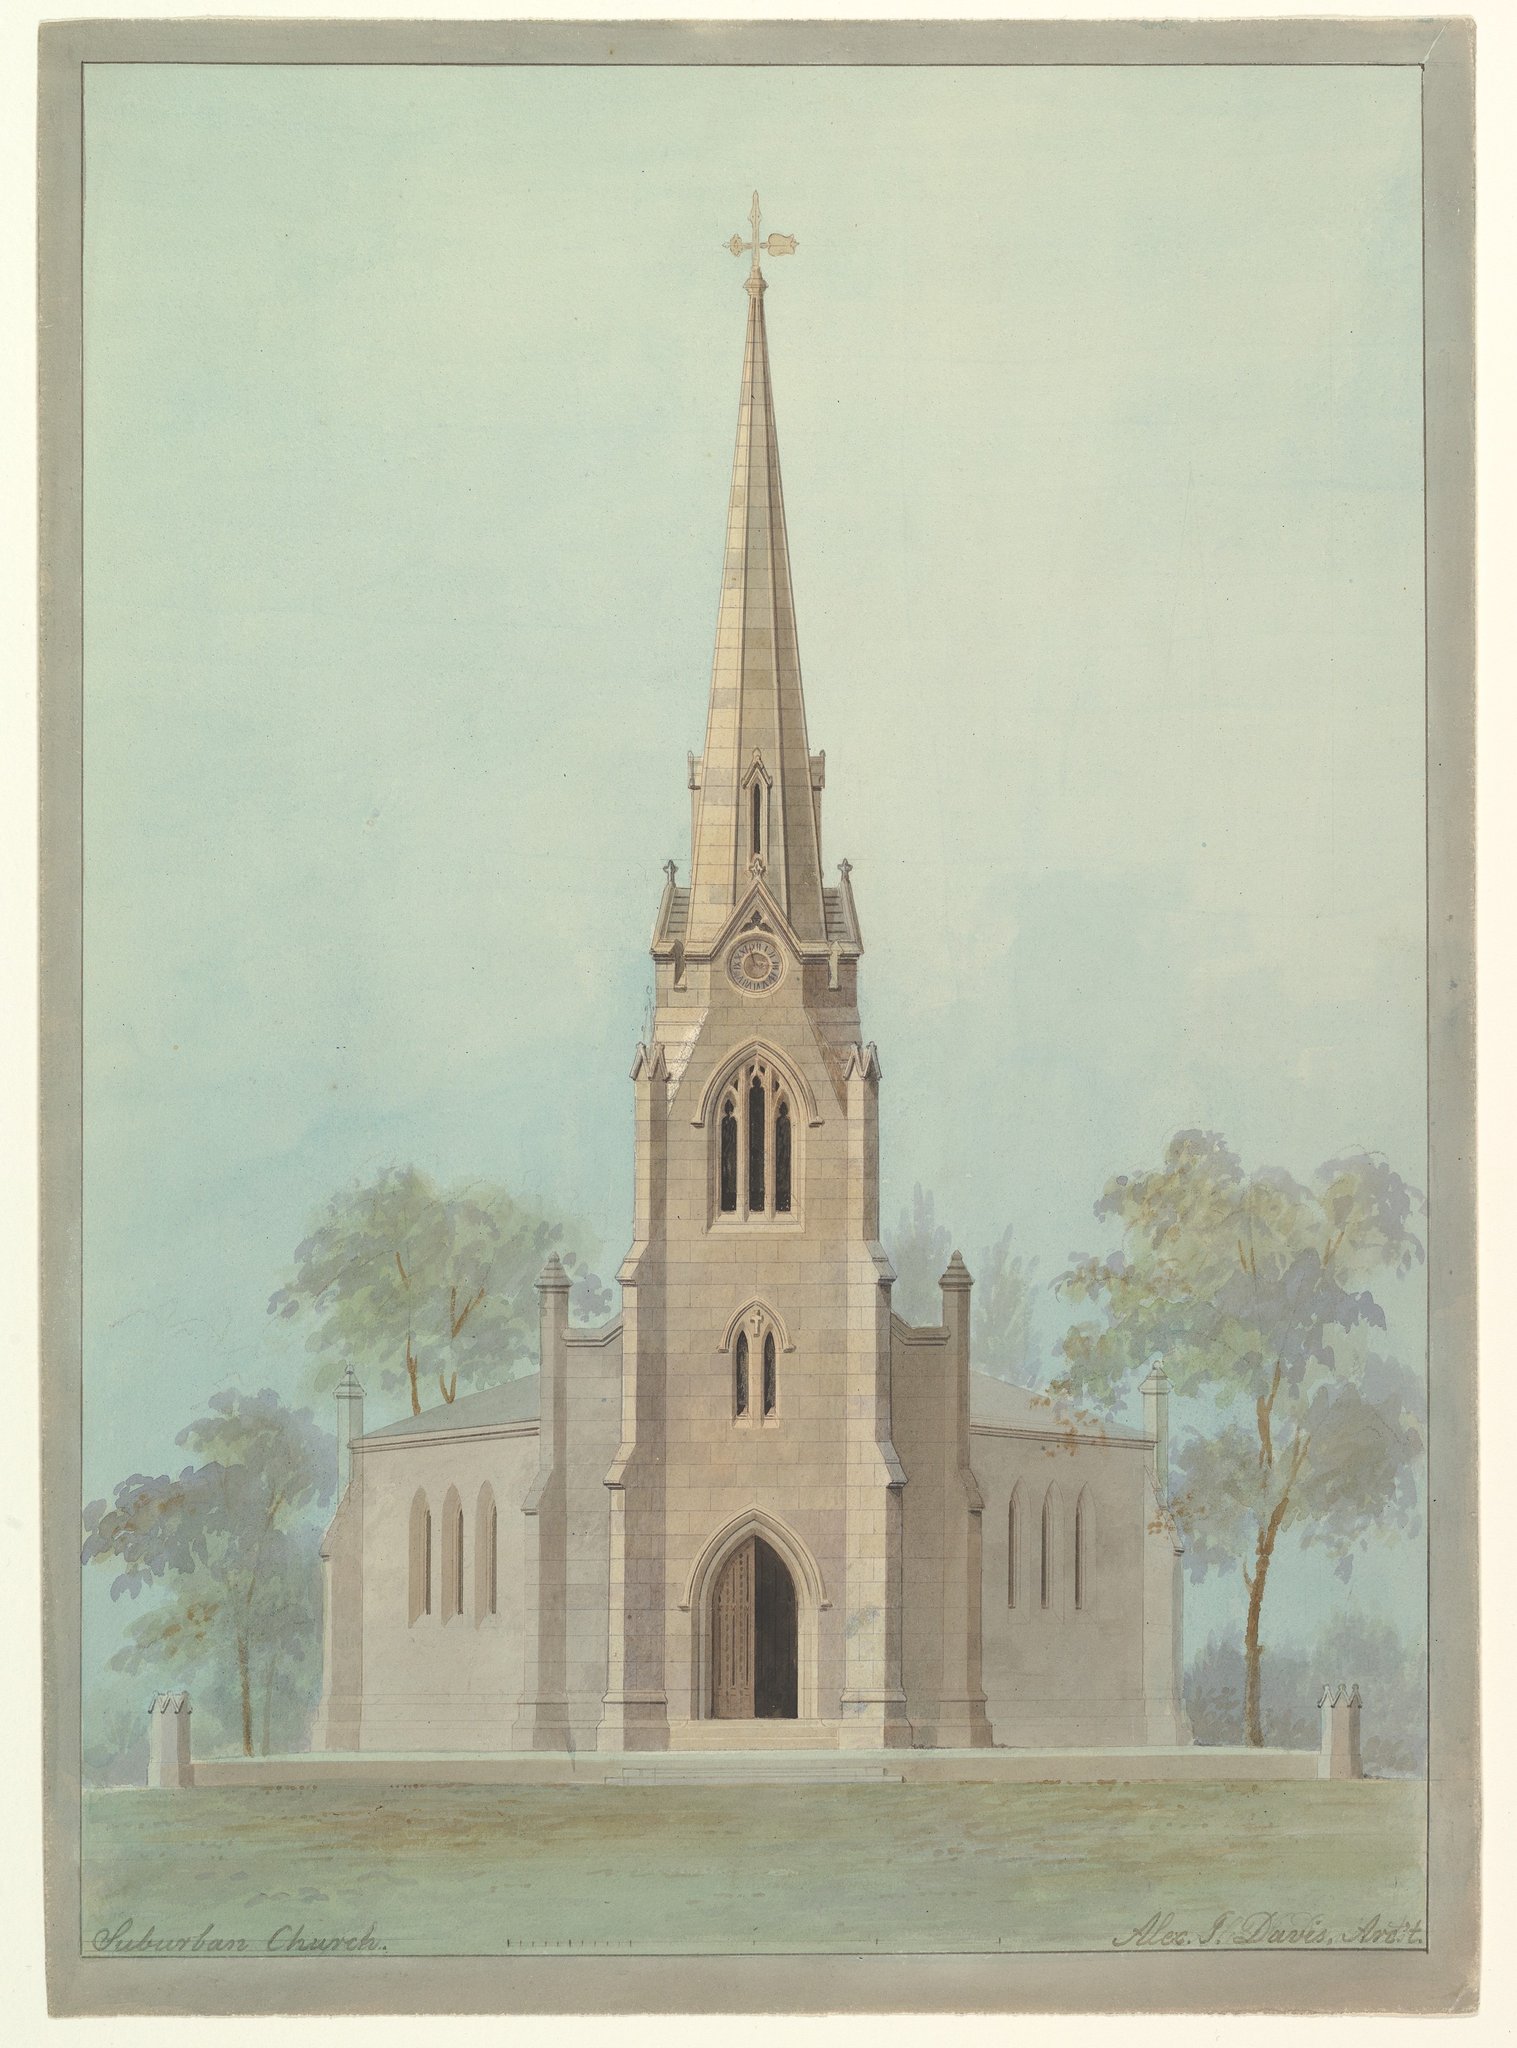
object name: drawing ornament architecture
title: Church of the Holy Apostles, New York City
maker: alexander jackson davis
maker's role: artist and architect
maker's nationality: american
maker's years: 1803-1892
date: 1845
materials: graphite, ink, paper, watercolor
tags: churches